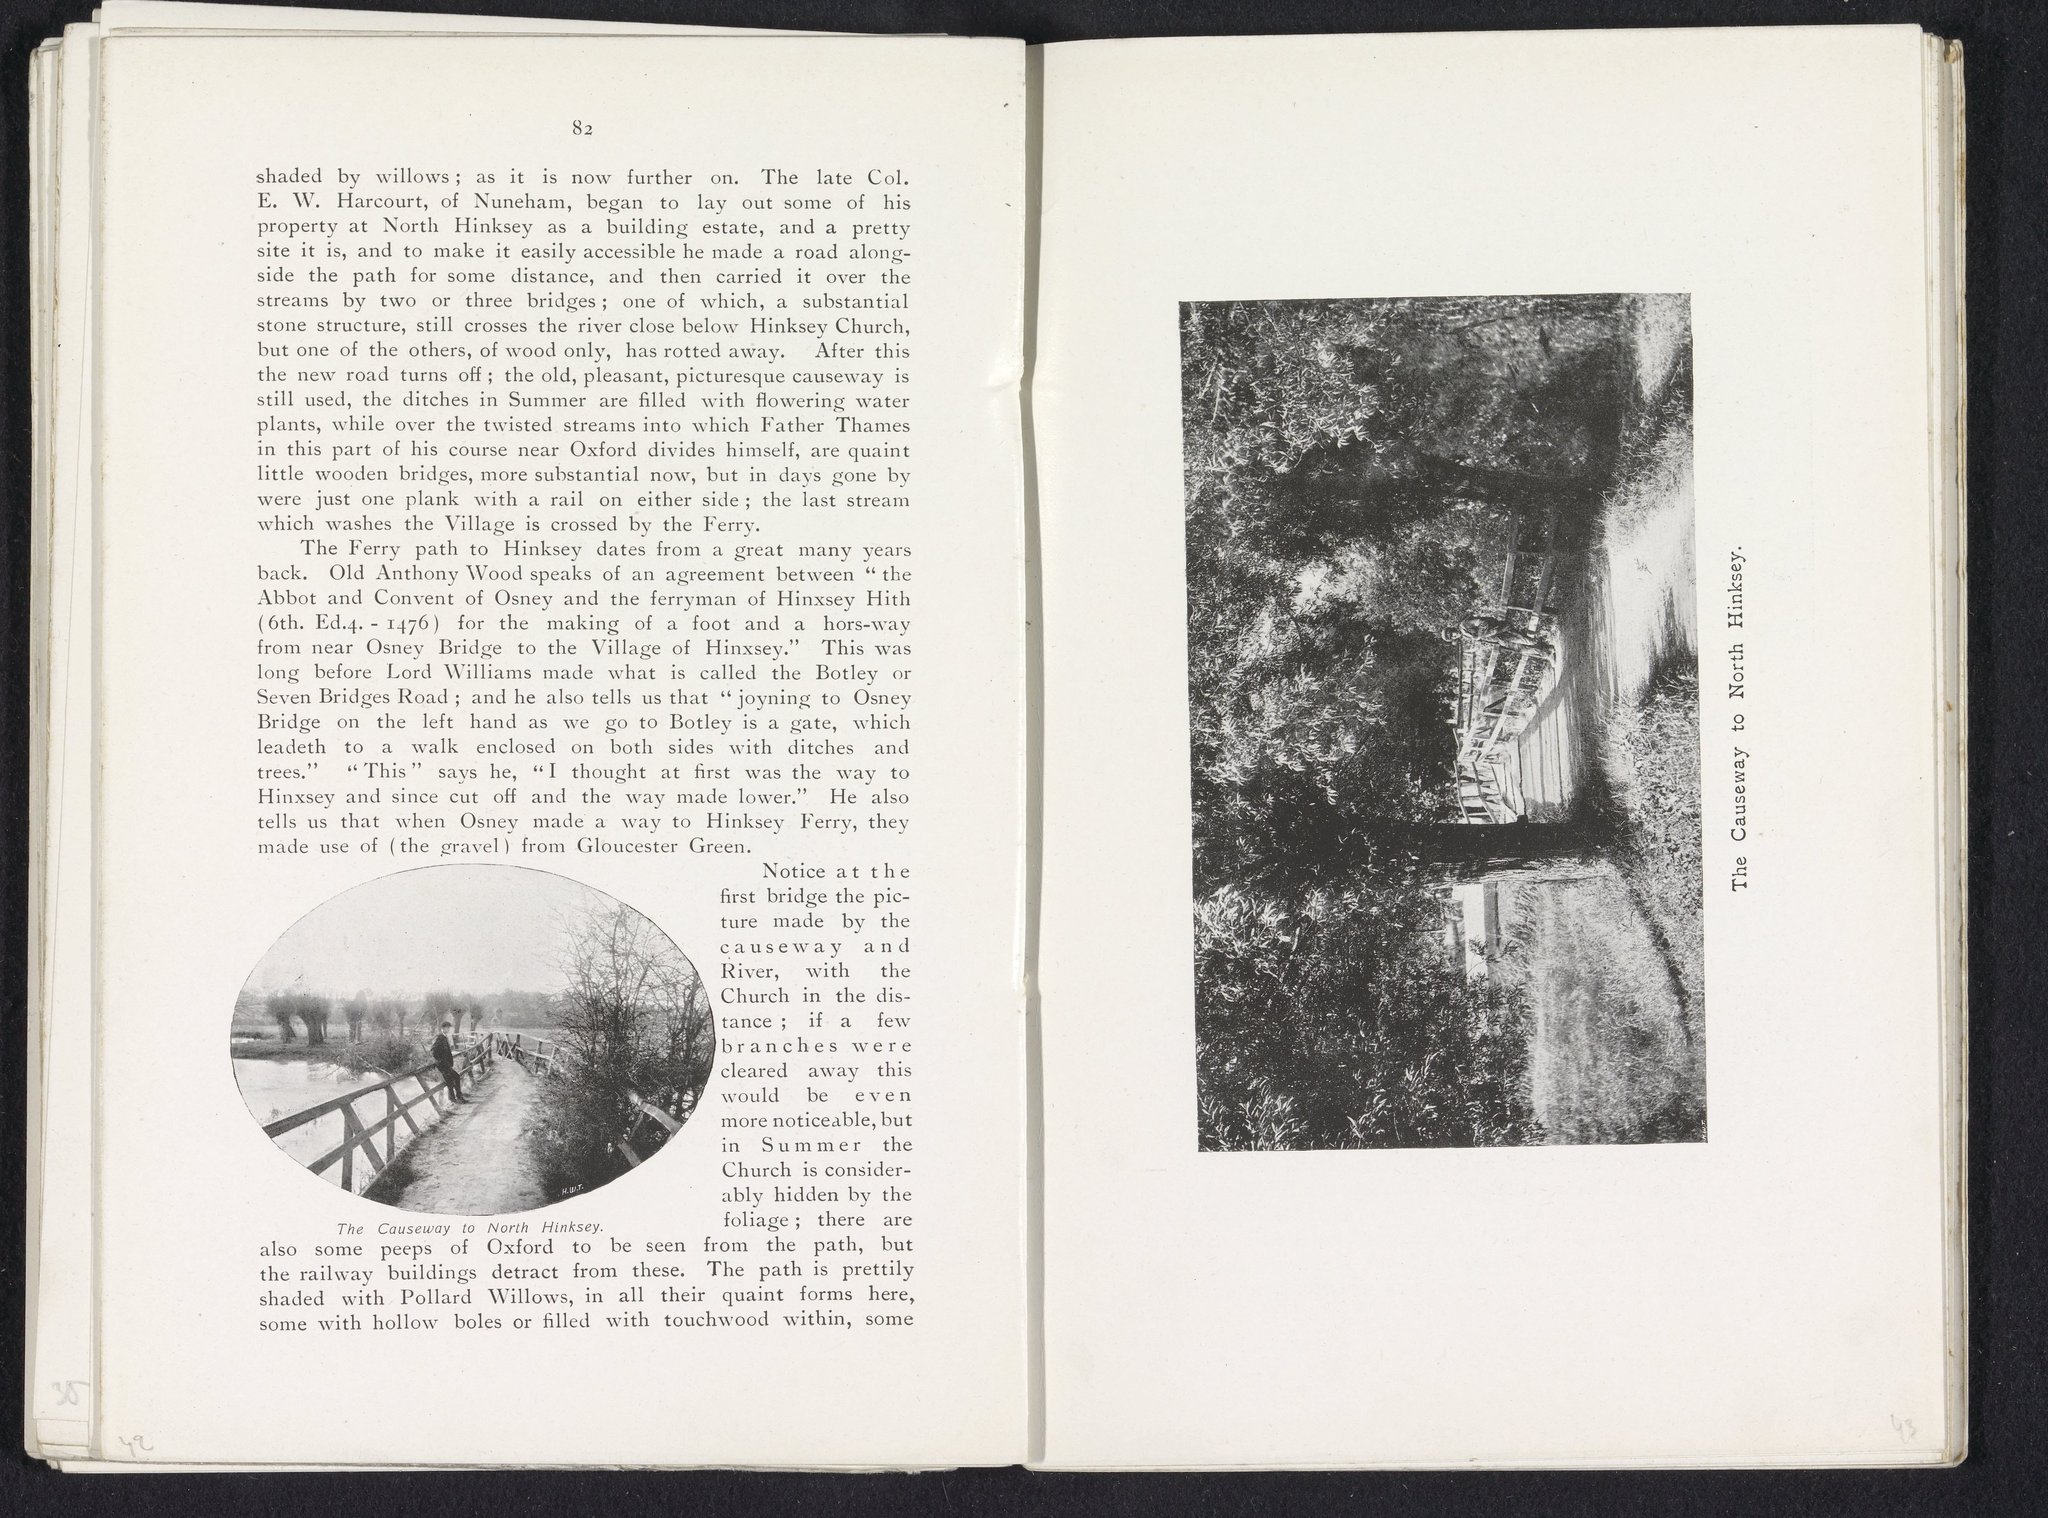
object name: page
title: The causeway to North Hinksey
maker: henry w. taunt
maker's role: fotograaf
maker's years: 1842-1922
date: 1907-1912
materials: paper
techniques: autotype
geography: oxfordshire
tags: adult man, public road in village, bridge